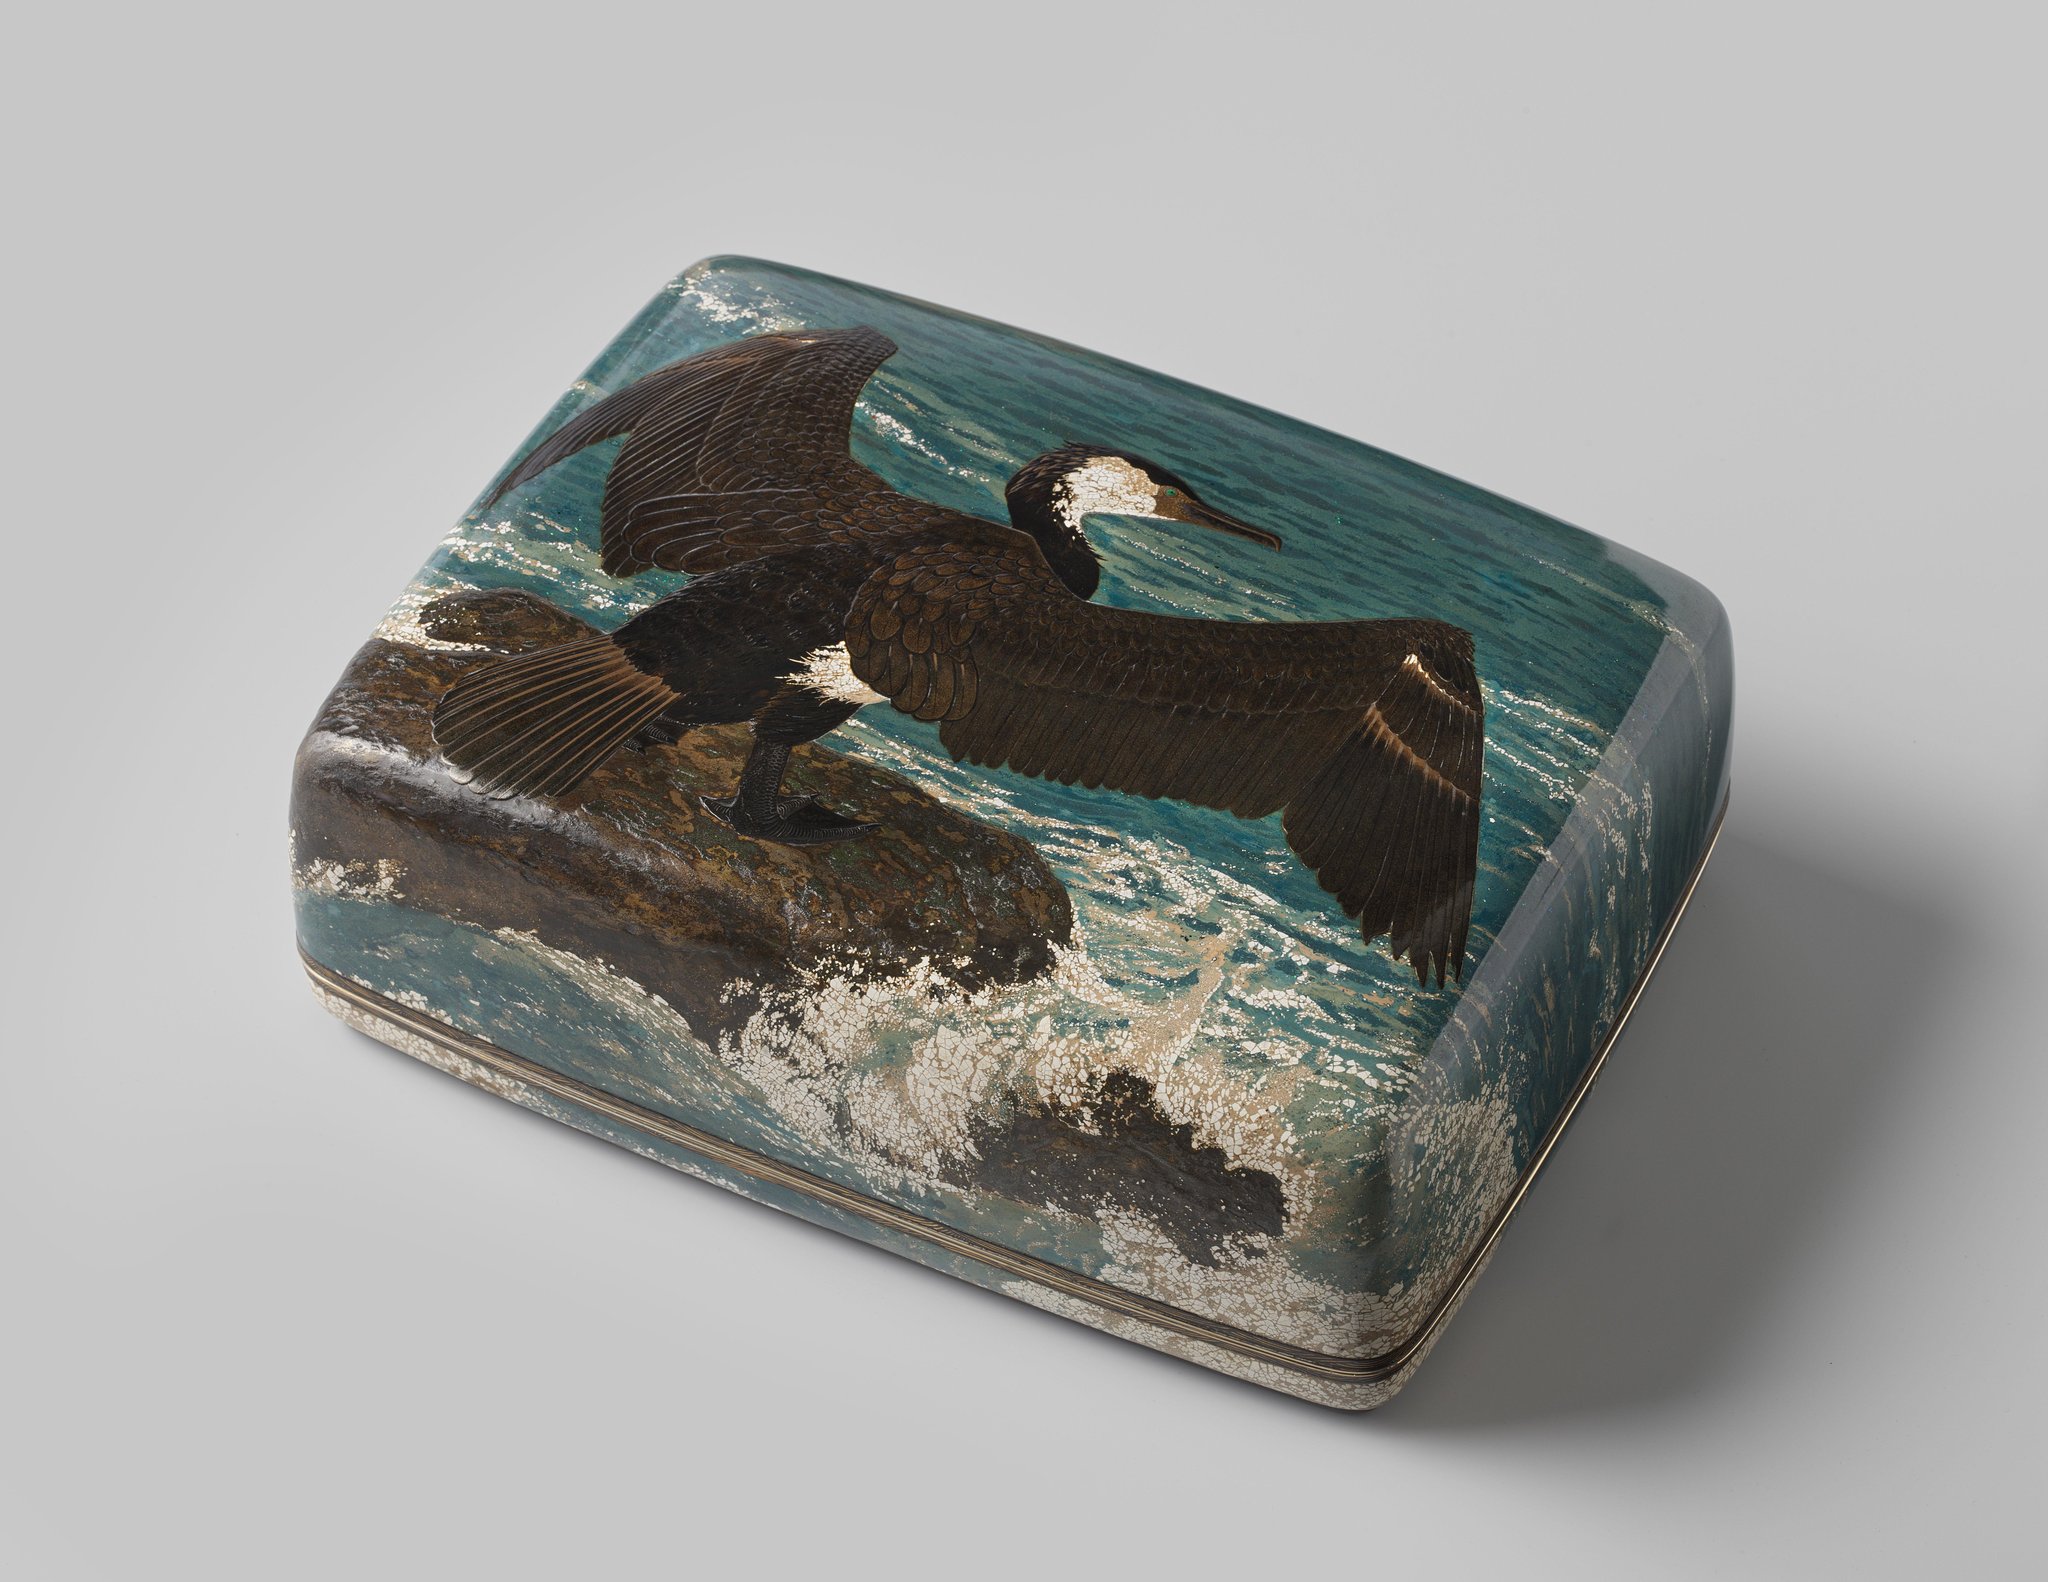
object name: box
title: Accessory Box ‘The Cormorant’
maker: rokkaku daijō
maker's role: lacquerer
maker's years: 1913-1973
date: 1938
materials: cotton, gold, lacquer, mother of pearl, silver, wood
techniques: lacquer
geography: japan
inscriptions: signature, inside lid wooden box, written in ink: ‘六角頴雄作’, date, inside lid wooden box, written in ink: ‘紀元二千六百年記念’, label, paper label, printed and written in ink: ‘命題 乾漆海鵜手筥 府縣 東京 作者 六角頴雄’ exhibition label, title, outside lid wooden box, written in ink: ‘海鵜乾漆手筥’, seal, inside lid wooden box, seal print in red ink: ‘六角’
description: kanshitsu (‘dry lacquer’), maki-e and eggshell and mother-of-pearl inlay The sea has been created by sprinkling various shades of blue lacquer chips and powder onto the still damp lacquer. The white foam is represented by numerous pieces of inlaid (quail) eggshell. It is almost as if we are looking at the bird on this box through binoculars. Never before had an animal figure been depicted so faithfully in lacquer. A Salon piece from 1938.